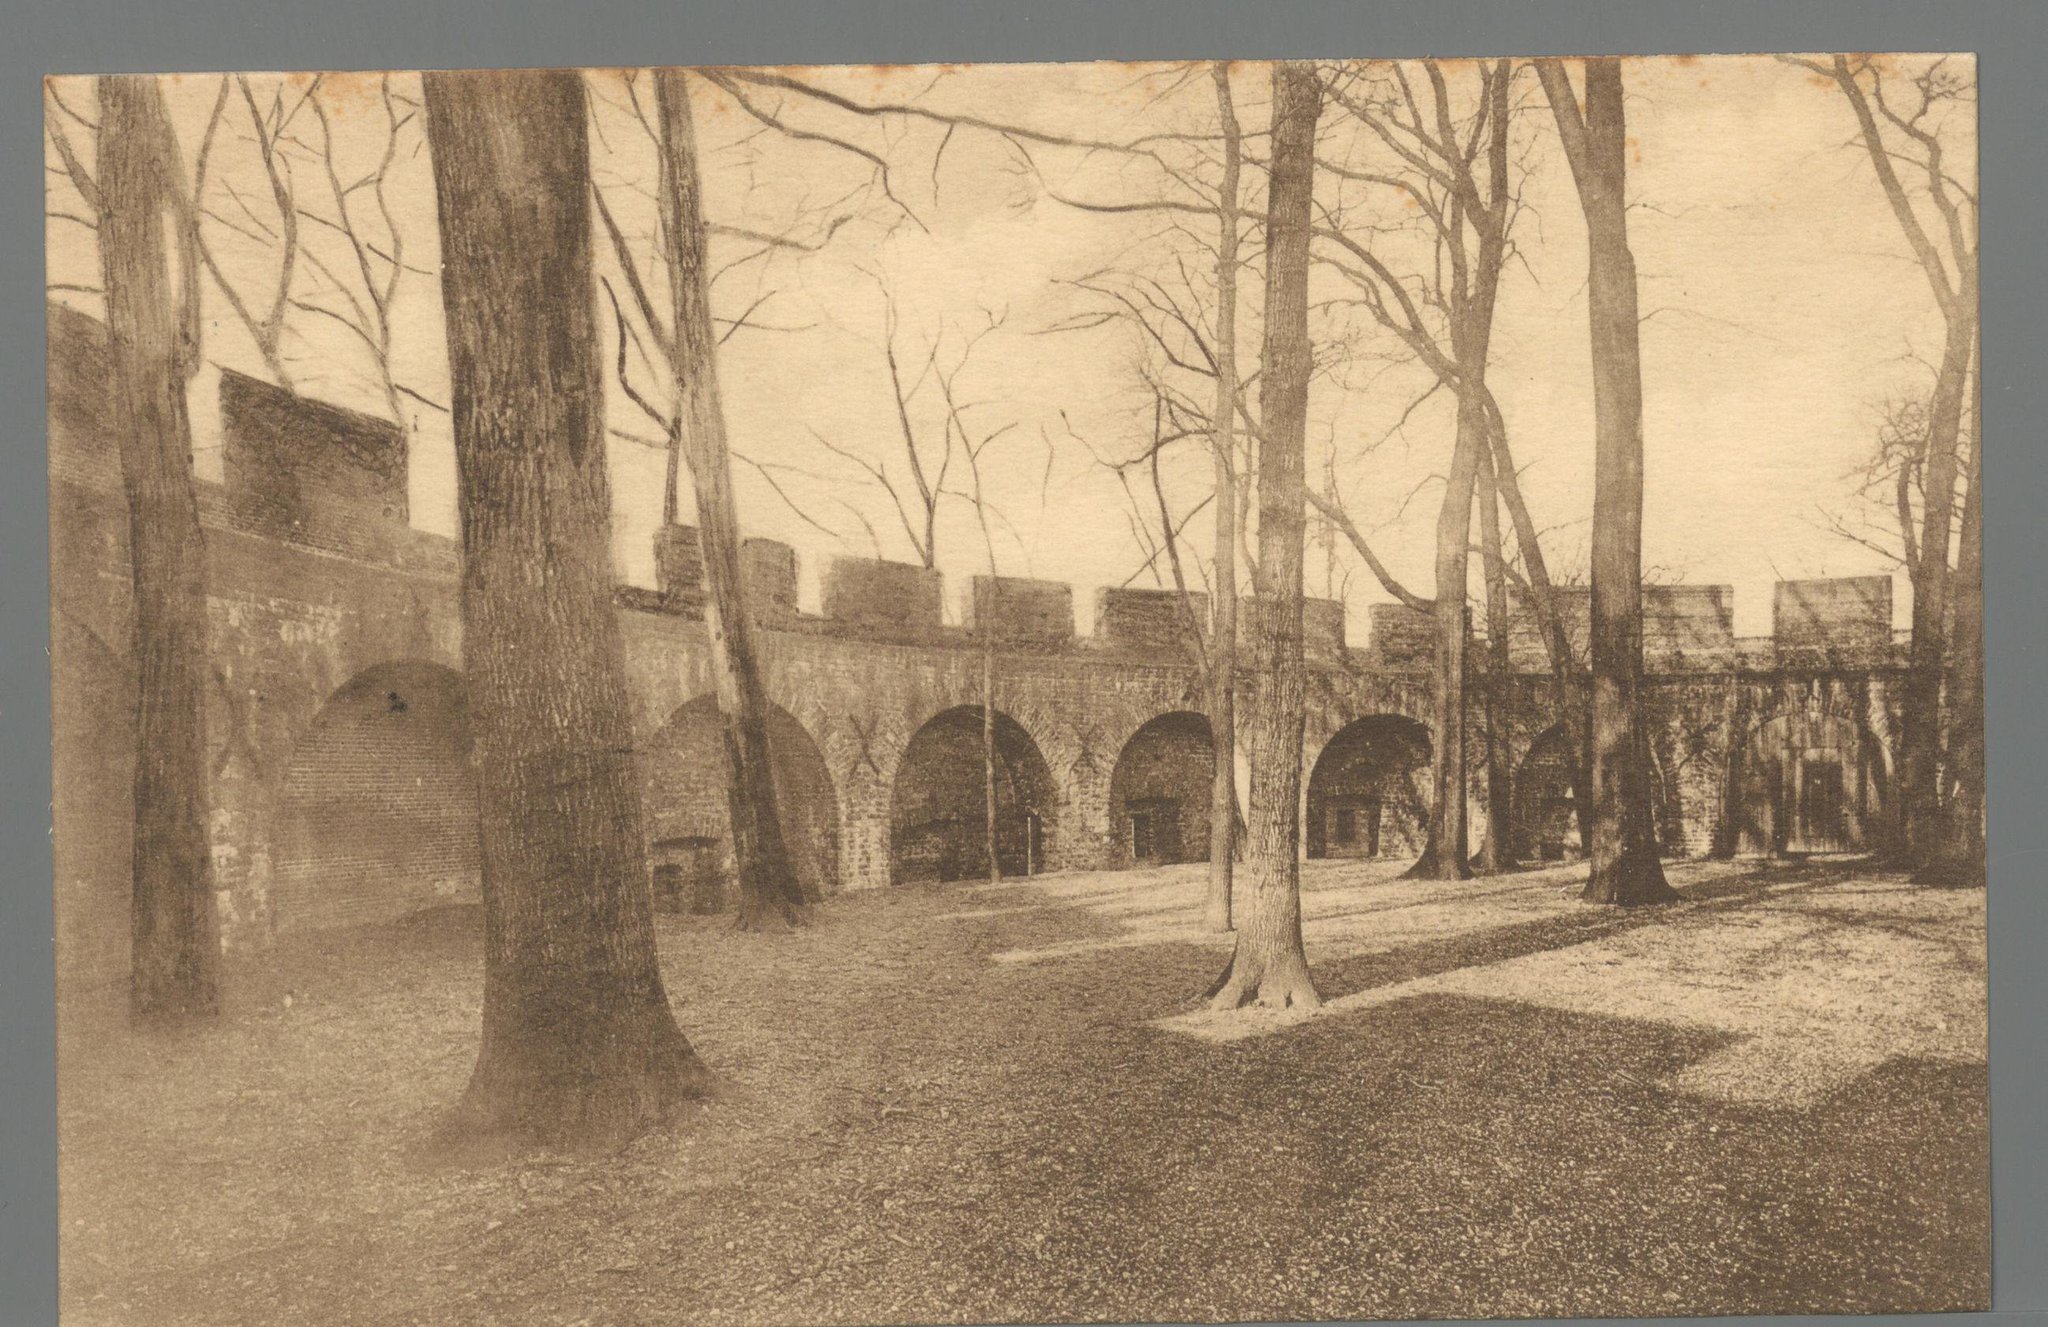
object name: photomechanical print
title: Leiden. Inwendige van den Burg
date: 1905-1930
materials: cardboard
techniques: photograph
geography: leiden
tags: castle